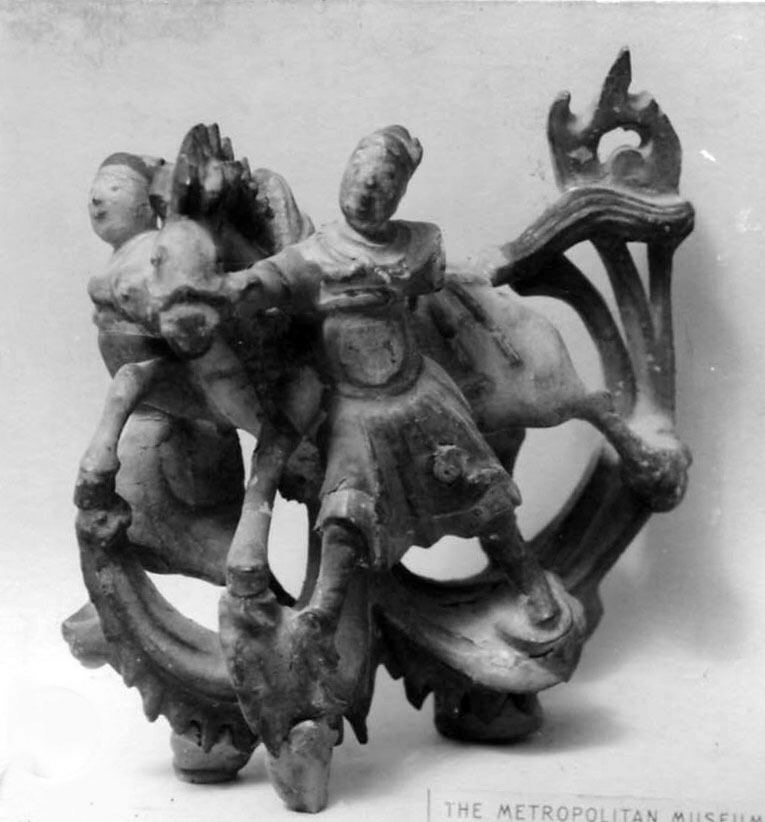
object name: statuette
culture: chinese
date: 1701-1800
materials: wood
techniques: painting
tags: men